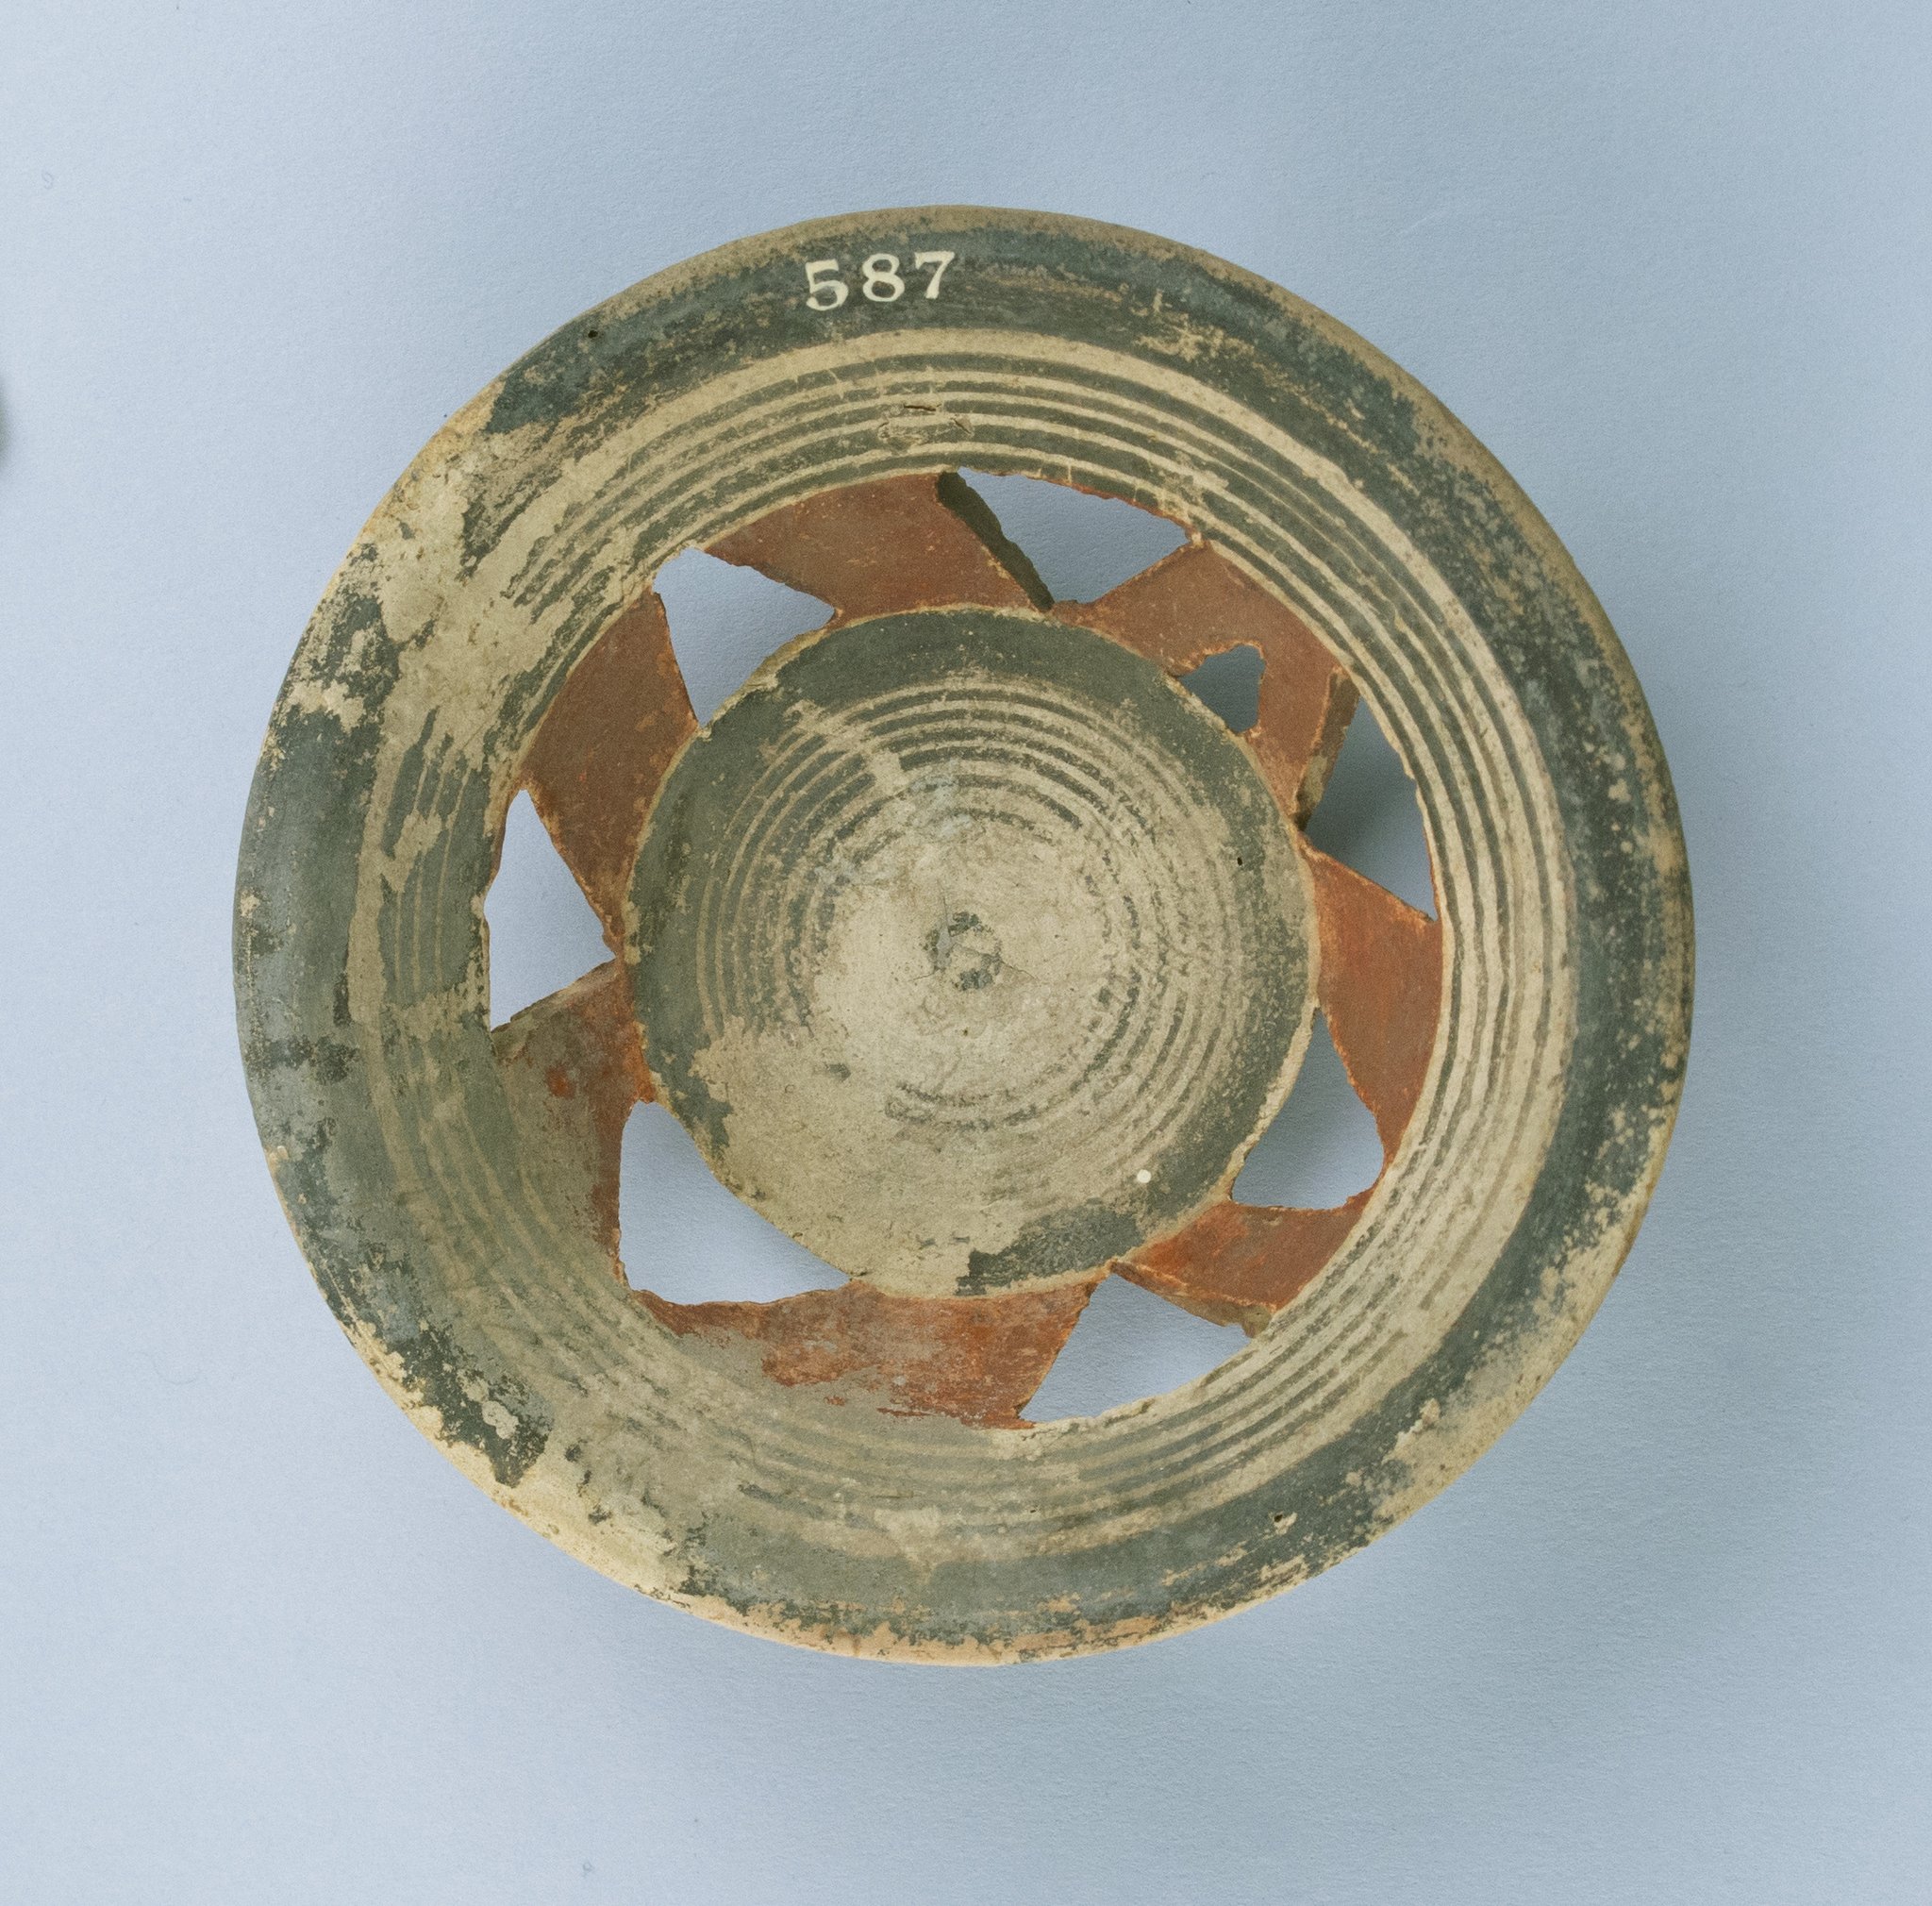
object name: bowl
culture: cypriot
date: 750-600 BCE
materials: terracotta